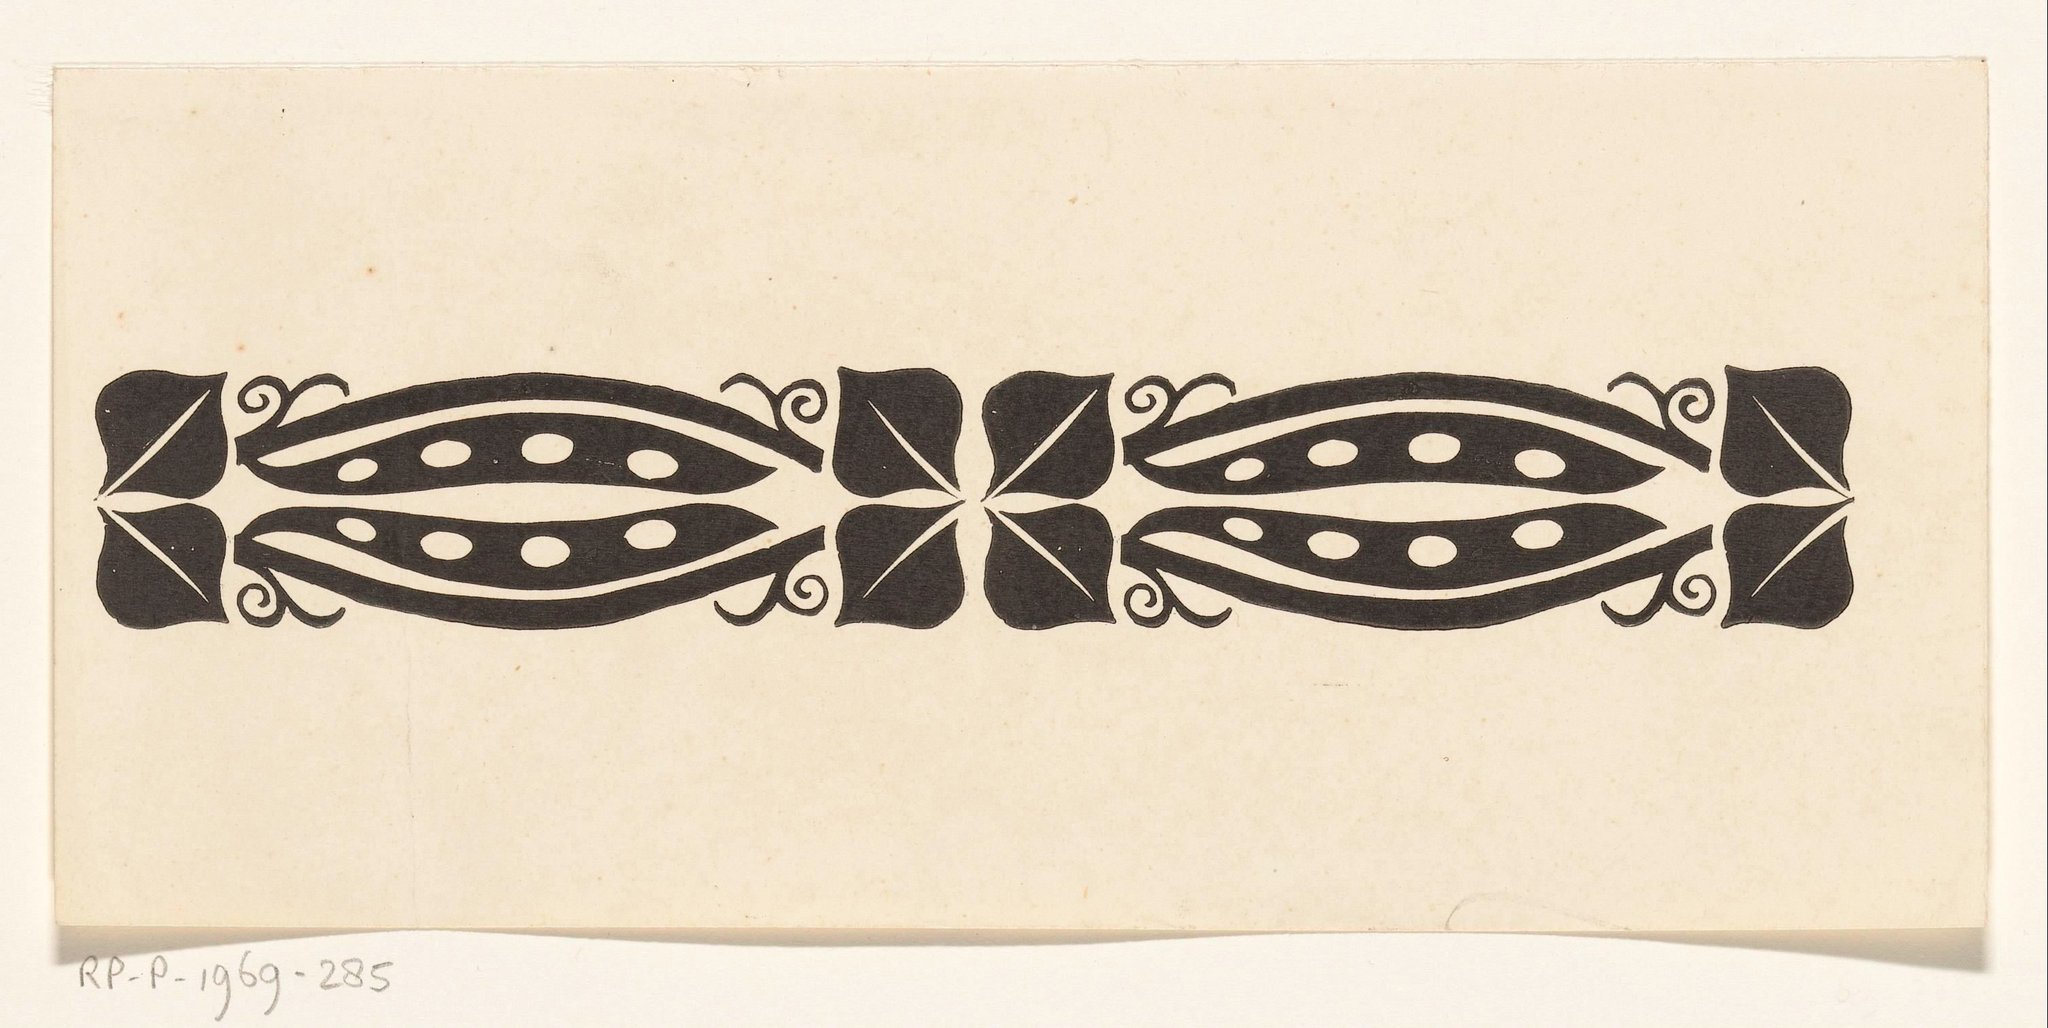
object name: print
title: Siermotief met vier peulvruchten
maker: carel adolph lion cachet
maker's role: draughtsman, print maker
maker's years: 1864-1945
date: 1874-1945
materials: paper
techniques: printing block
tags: ornament derived from plant forms - aa - stylized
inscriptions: collector's mark: Lugt 2228